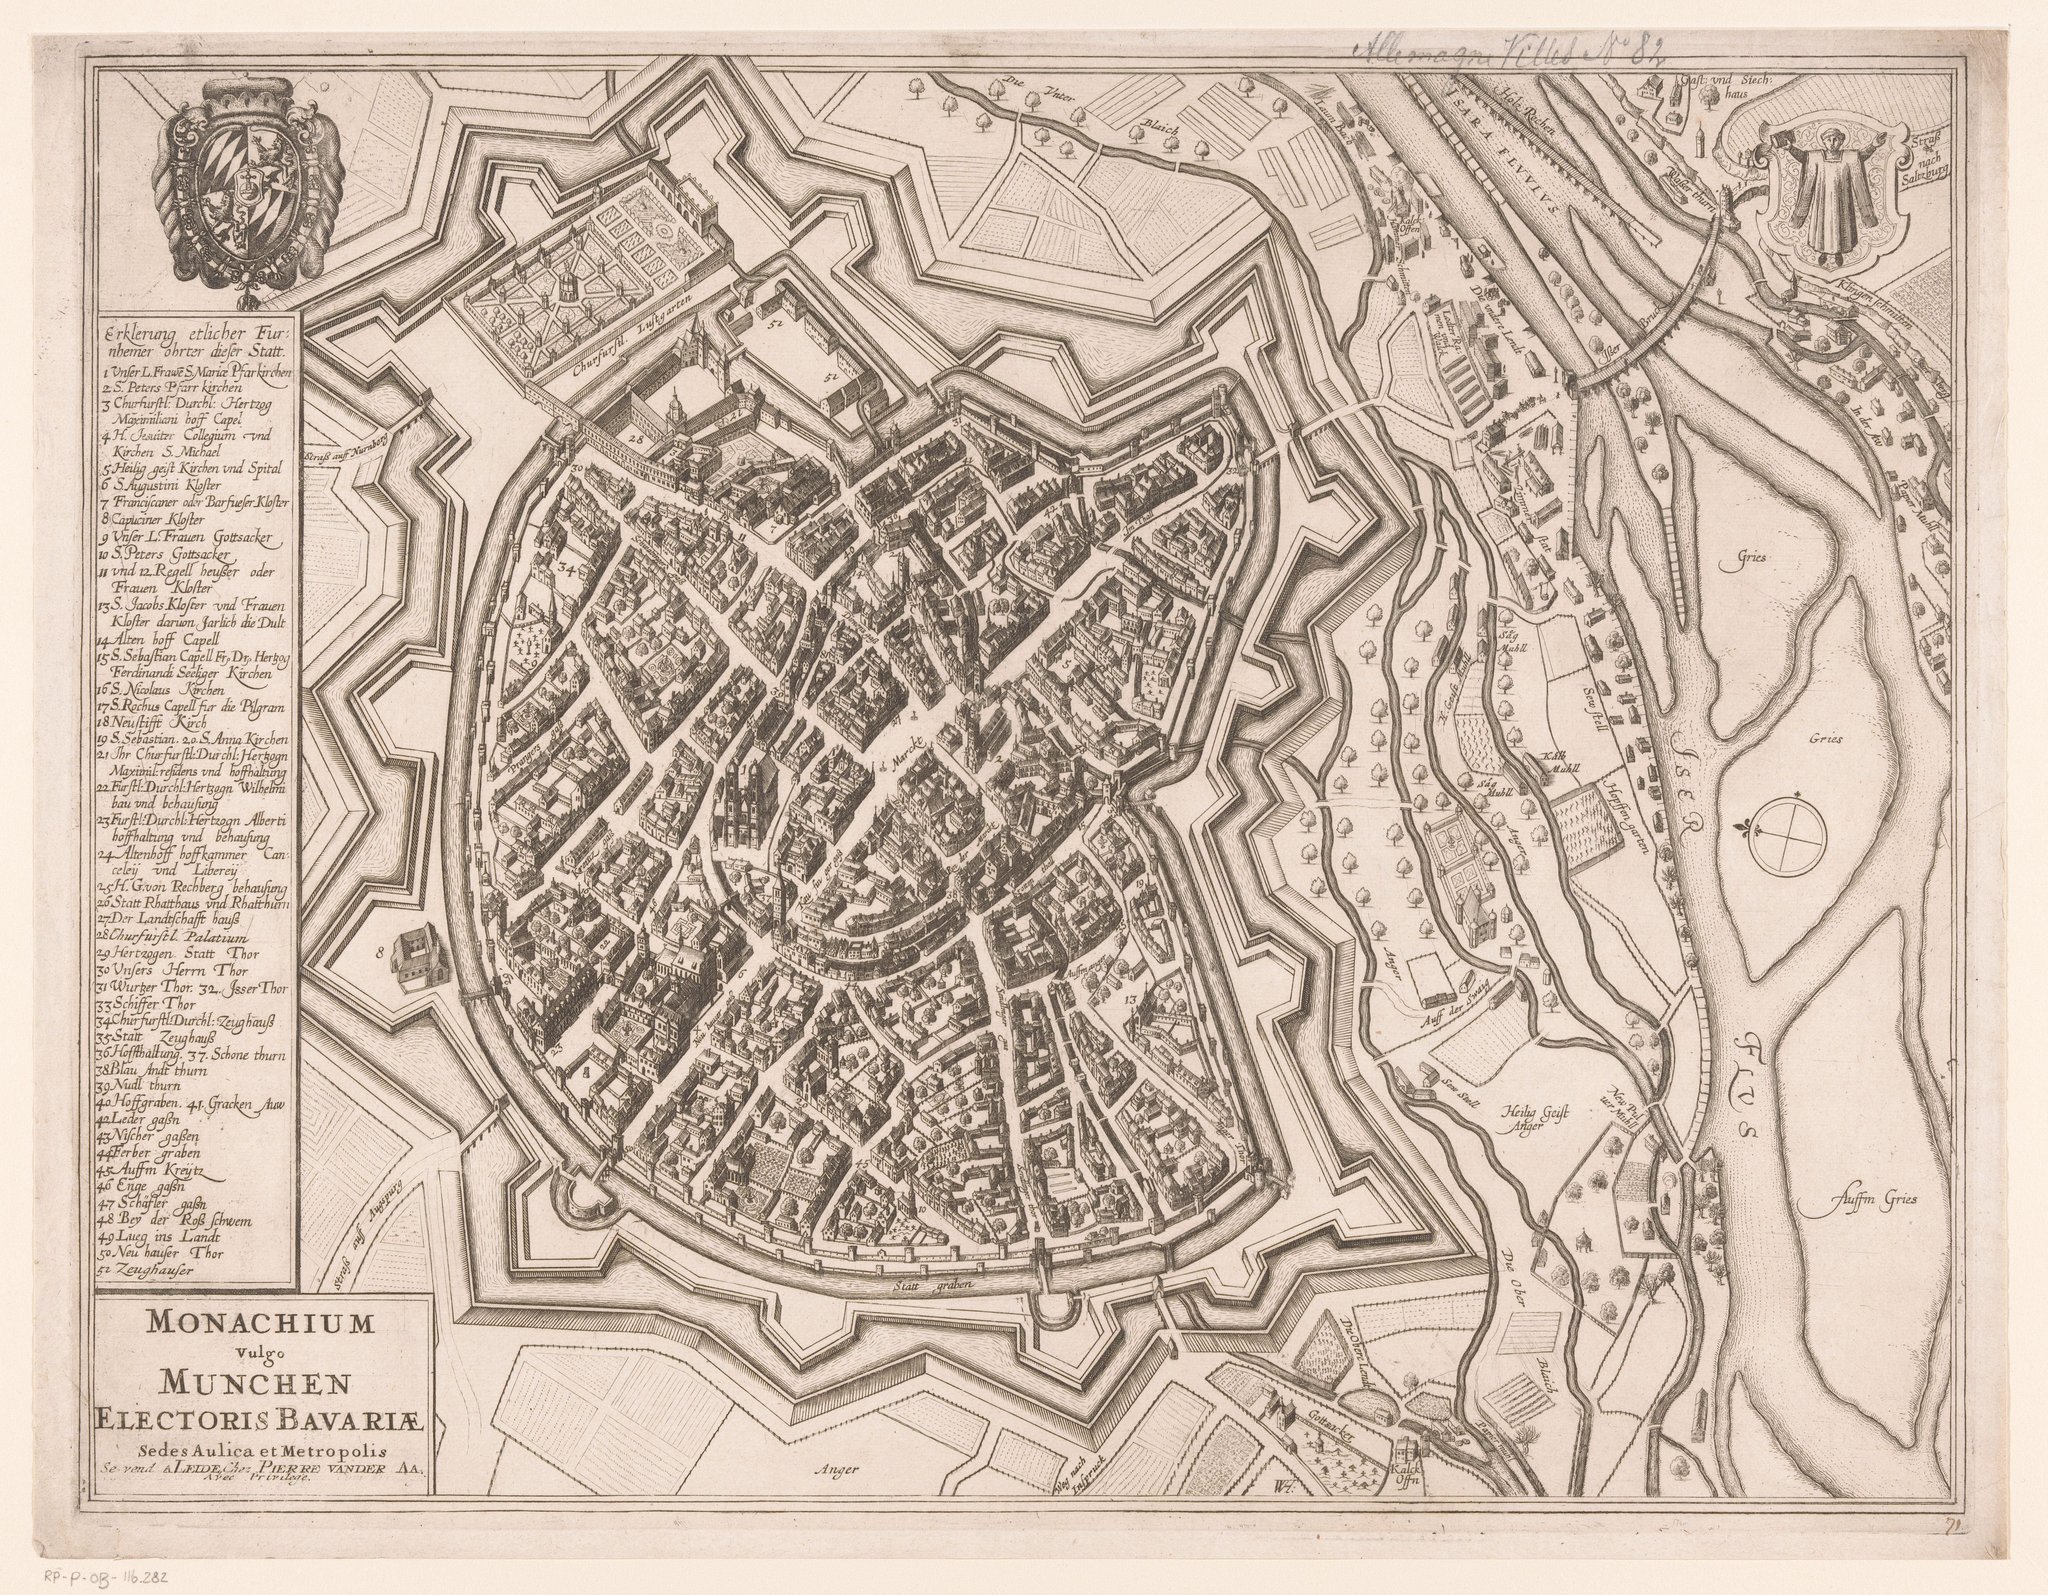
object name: print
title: Plattegrond van München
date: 1729-1733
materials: paper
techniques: etching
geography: germany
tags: fortified city, coat of arms (as symbol of the state, etc.) (+ province; provincial), prospect of city, town panorama, silhouette of city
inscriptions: annotation: ‘Allemagne (...)’, annotation: ‘70.’, collector's mark: Lugt 2228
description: Deze prent maakt deel uit van een serie van 500 prenten. Prent gebruikt in: Civitates orbis terrarum. Urbium totius Germaniae superioris. Amsterdam: Johannes Janssonius, 1657, dl. 3-4. Deze prent is gebruikt in: La Galerie Agréable du Monde. Leiden: Pieter van der Aa, 1728.